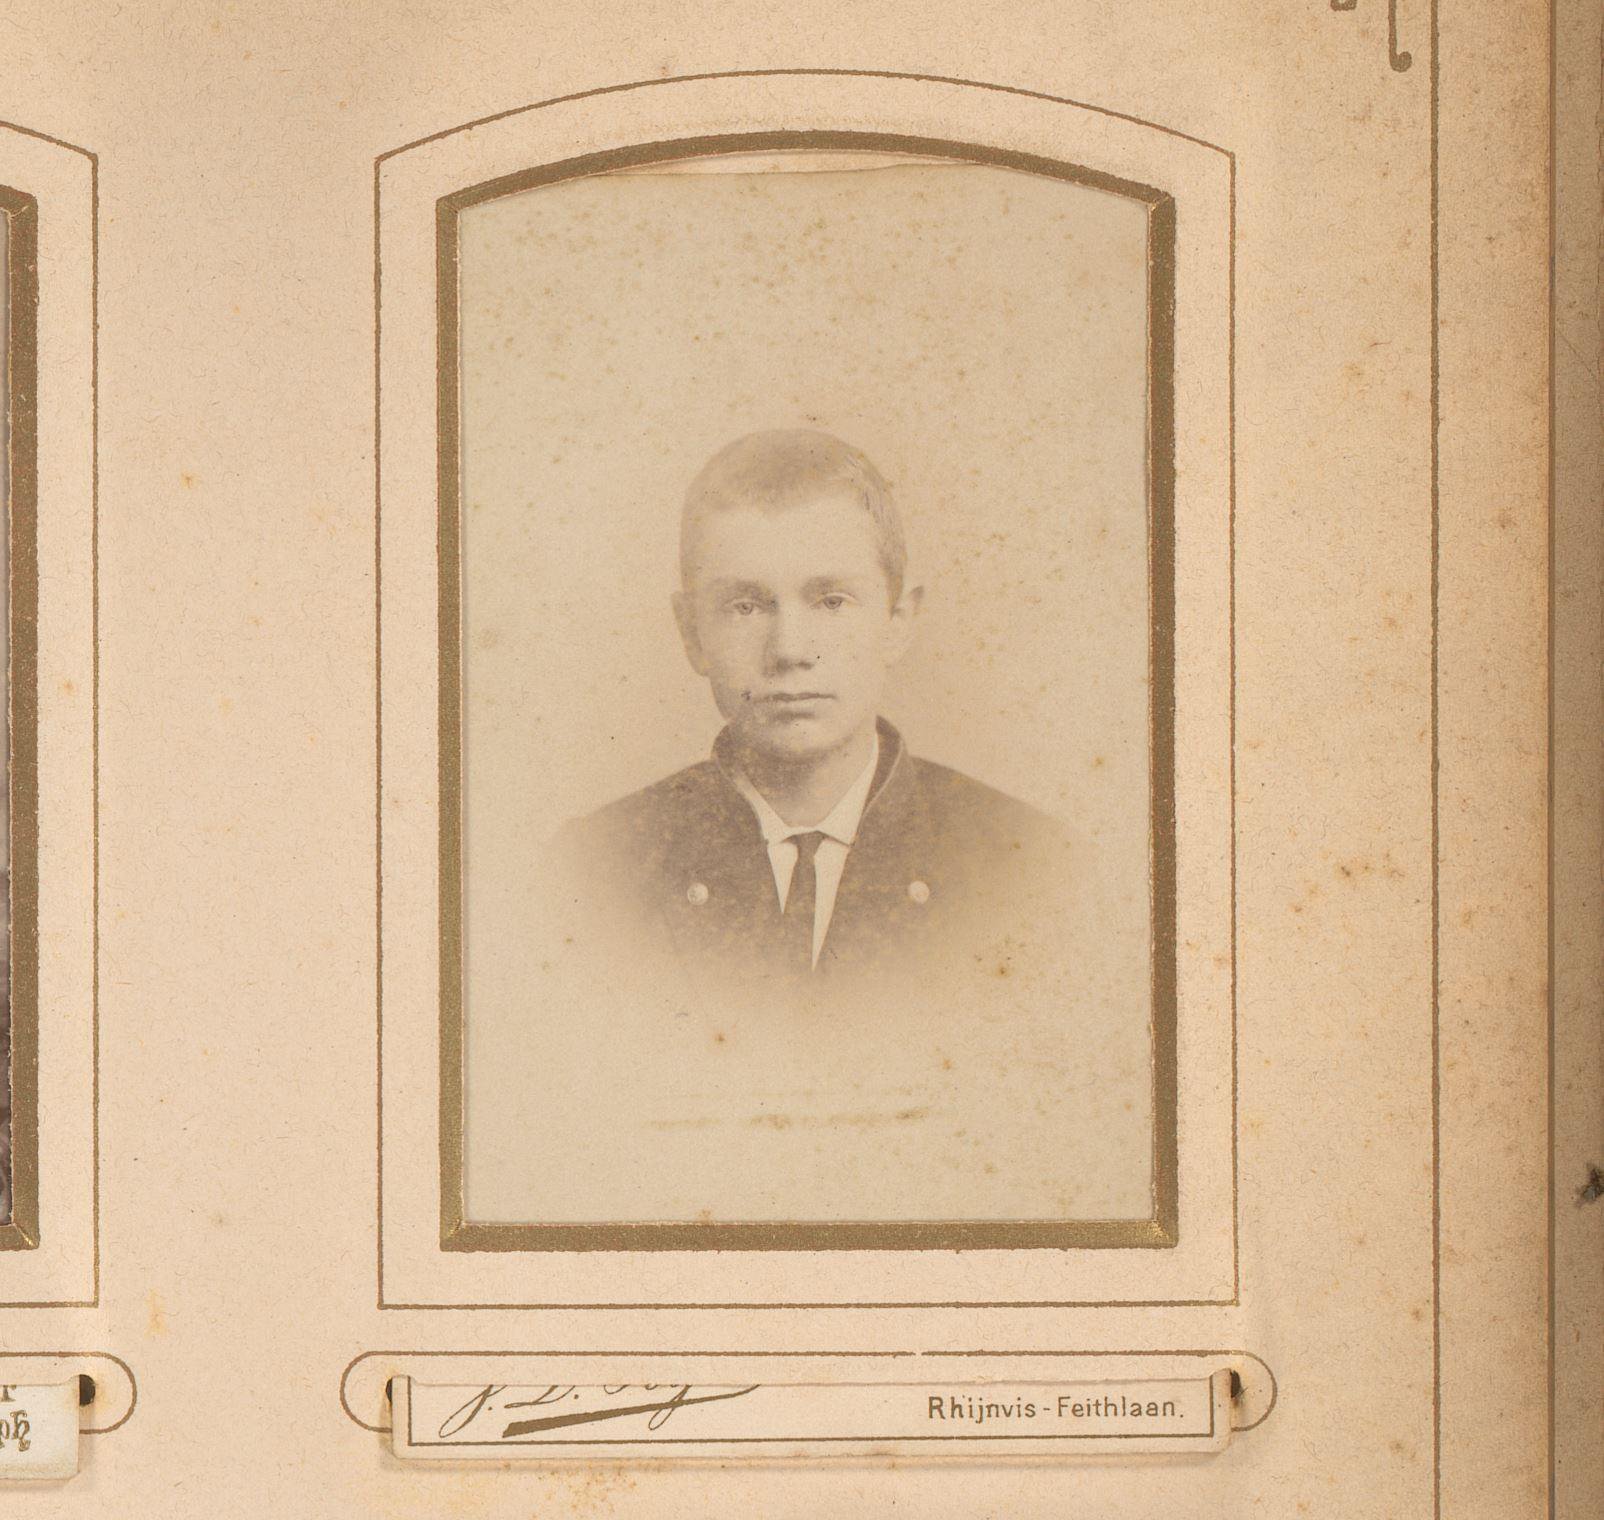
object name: photograph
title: Portret van een jongen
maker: jacques daniël rijk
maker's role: draughtsman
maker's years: 1855-1912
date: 1888-1894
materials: cardboard, photographic support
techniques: albumen print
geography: zwolle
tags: boy (child between toddler and youth), historical persons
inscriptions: inscription: ‘J.D. Rijk/ Zwolle/ Rhijnvis - Feithlaan’